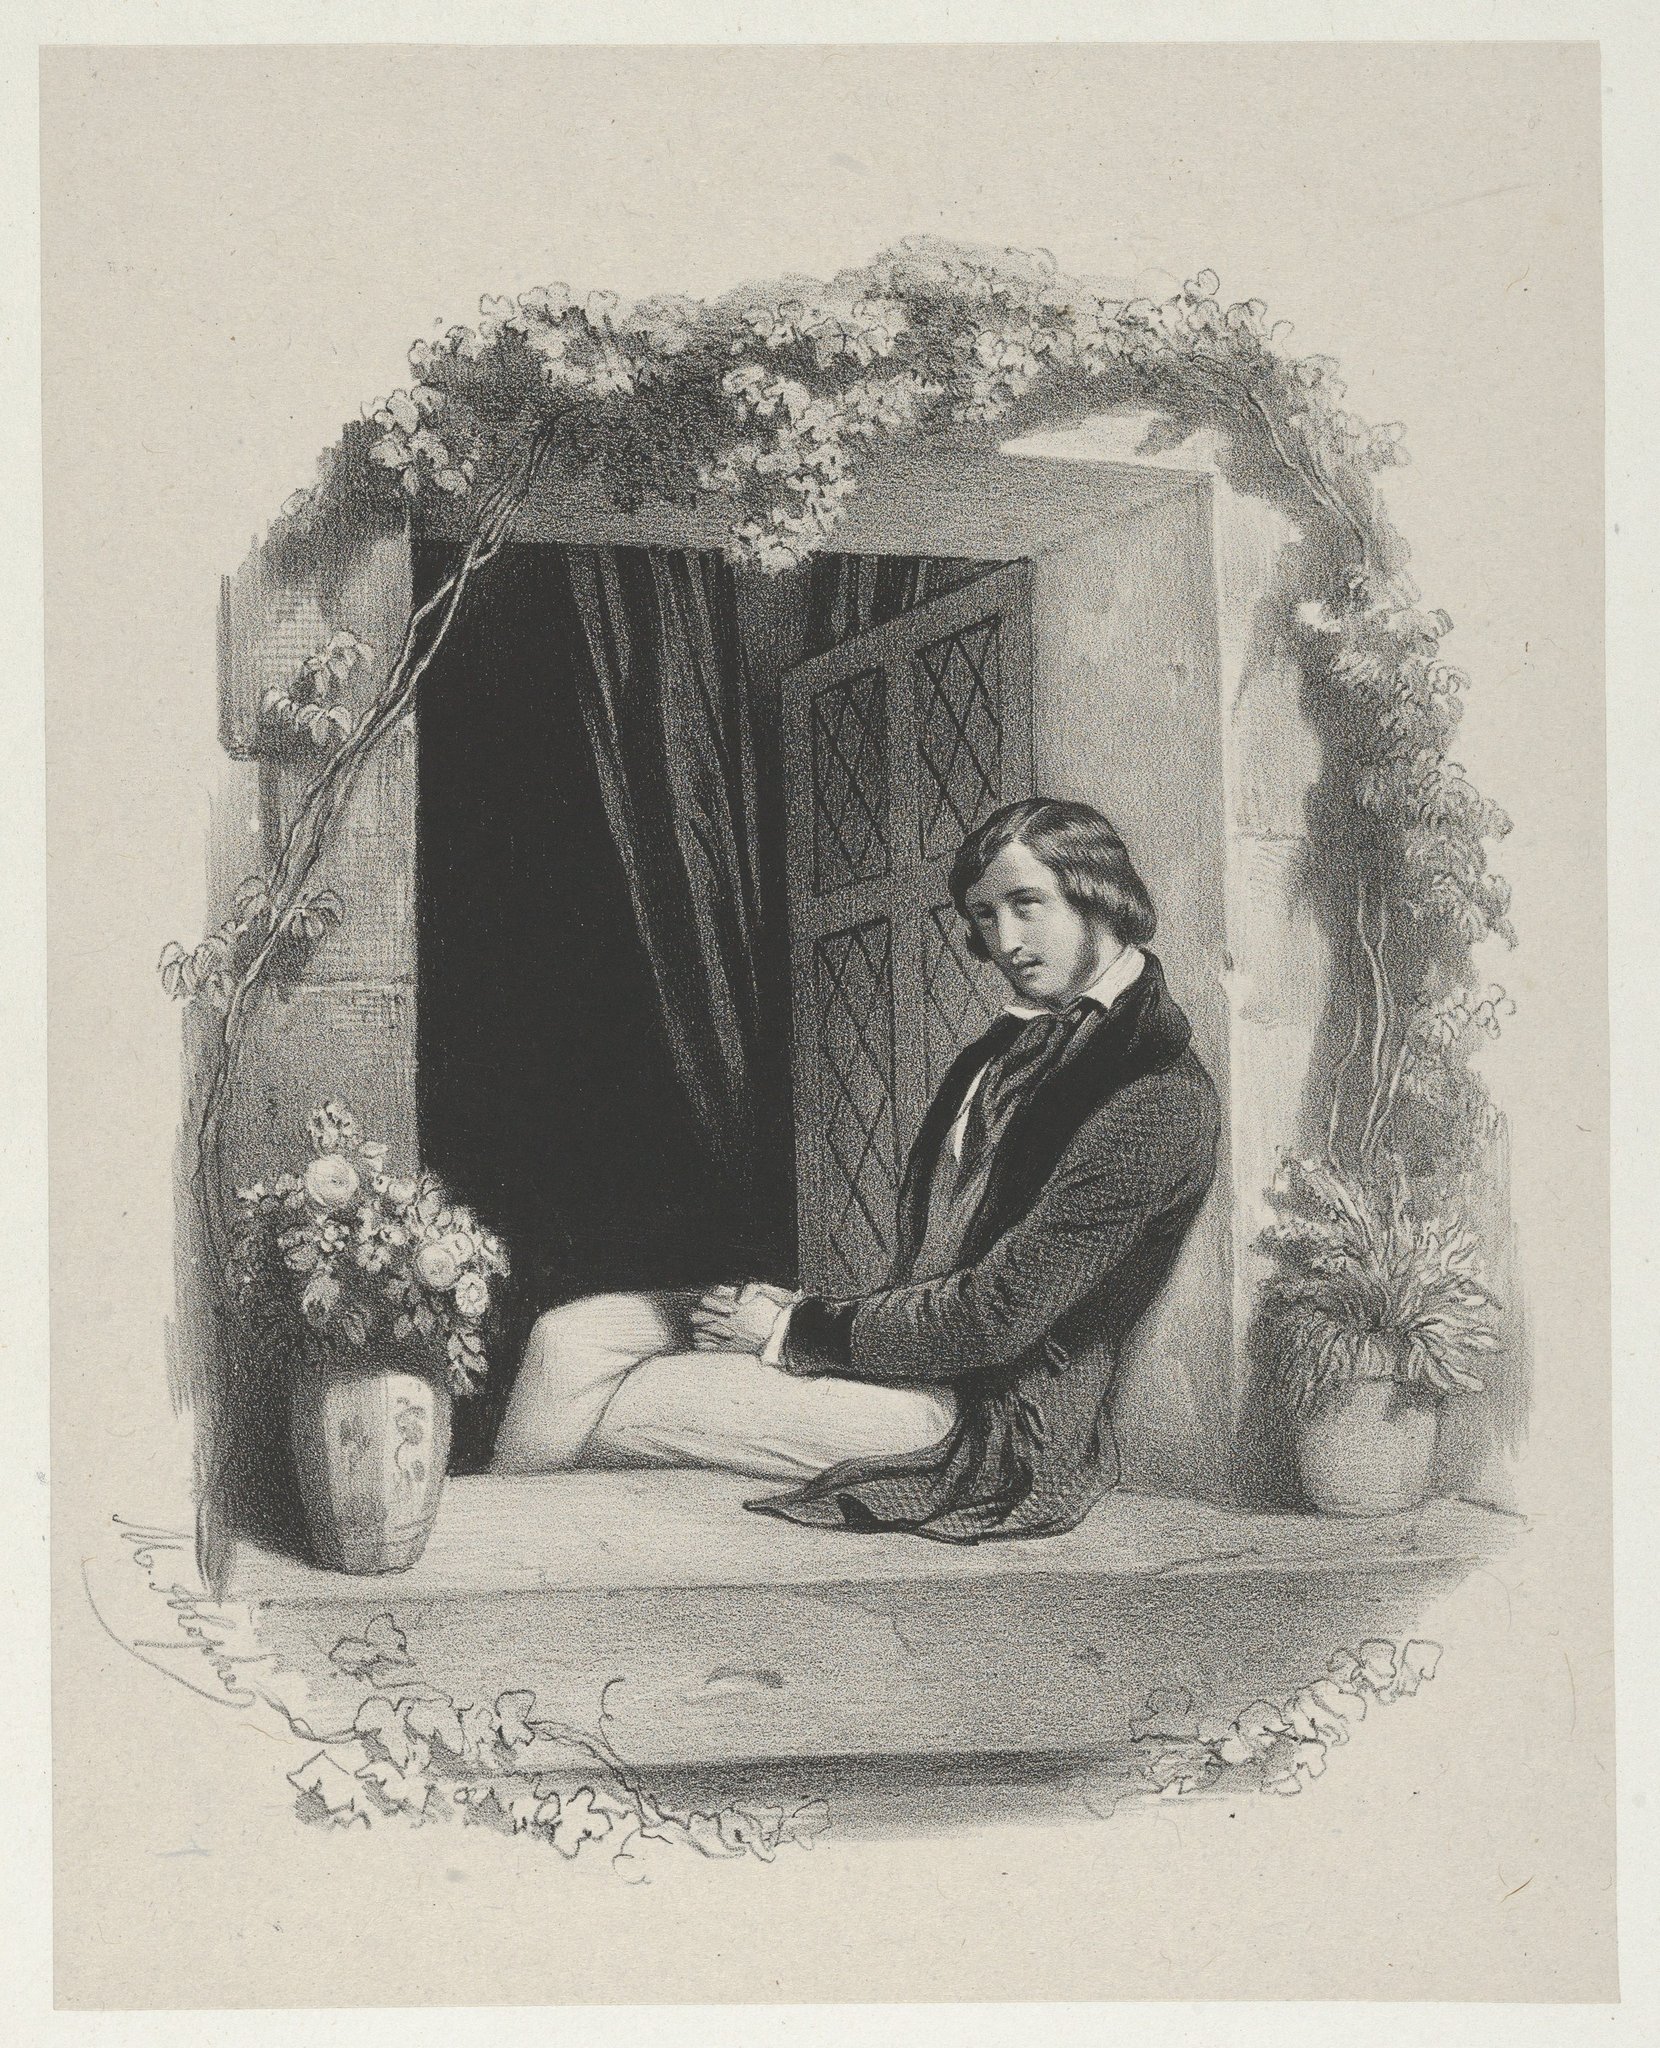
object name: print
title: Melancholy, young man with folded hands sitting on window sill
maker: marie-alexandre alophe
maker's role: artist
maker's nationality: french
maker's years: 1811-1883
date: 1801-1900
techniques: lithograph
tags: windows,men